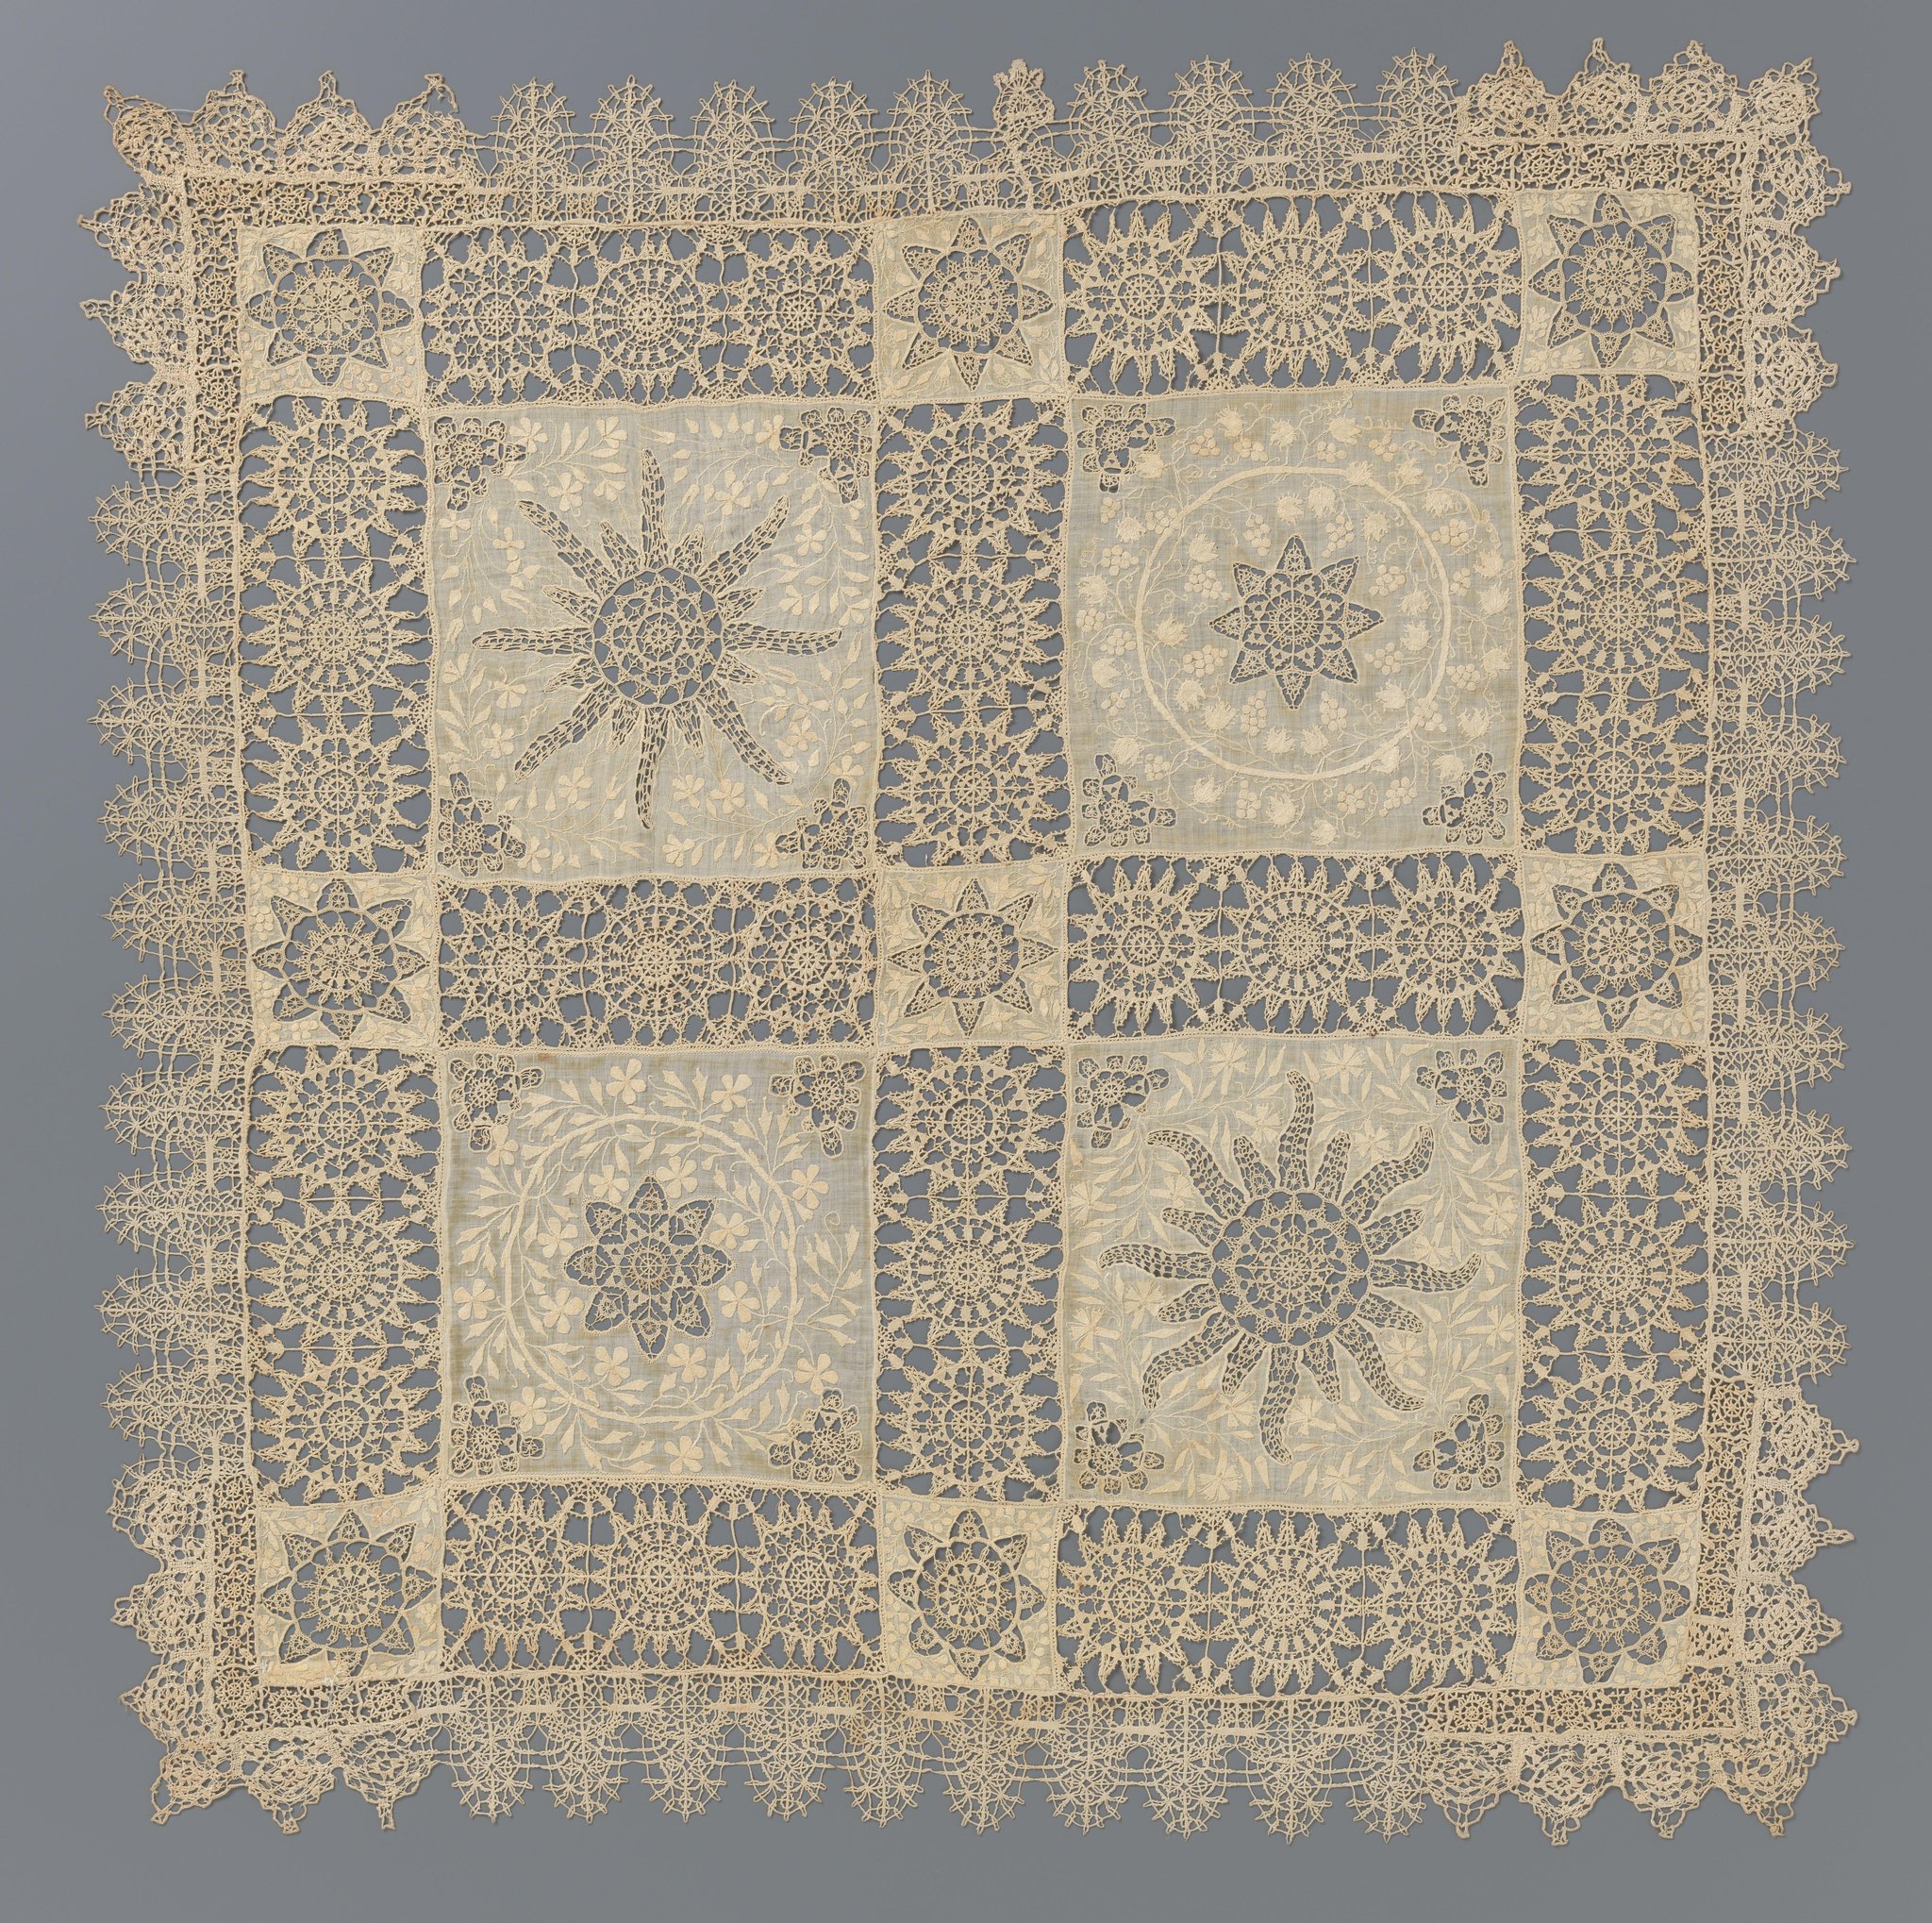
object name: pillowcase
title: Sloop van naald- en kloskant en borduurwerk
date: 1600-1625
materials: lace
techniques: lace, embroidered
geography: western europe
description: Sloop van naald- en kloskant en borduurwerk, met bijbehorende sprei en een tweede sloop (A,C)